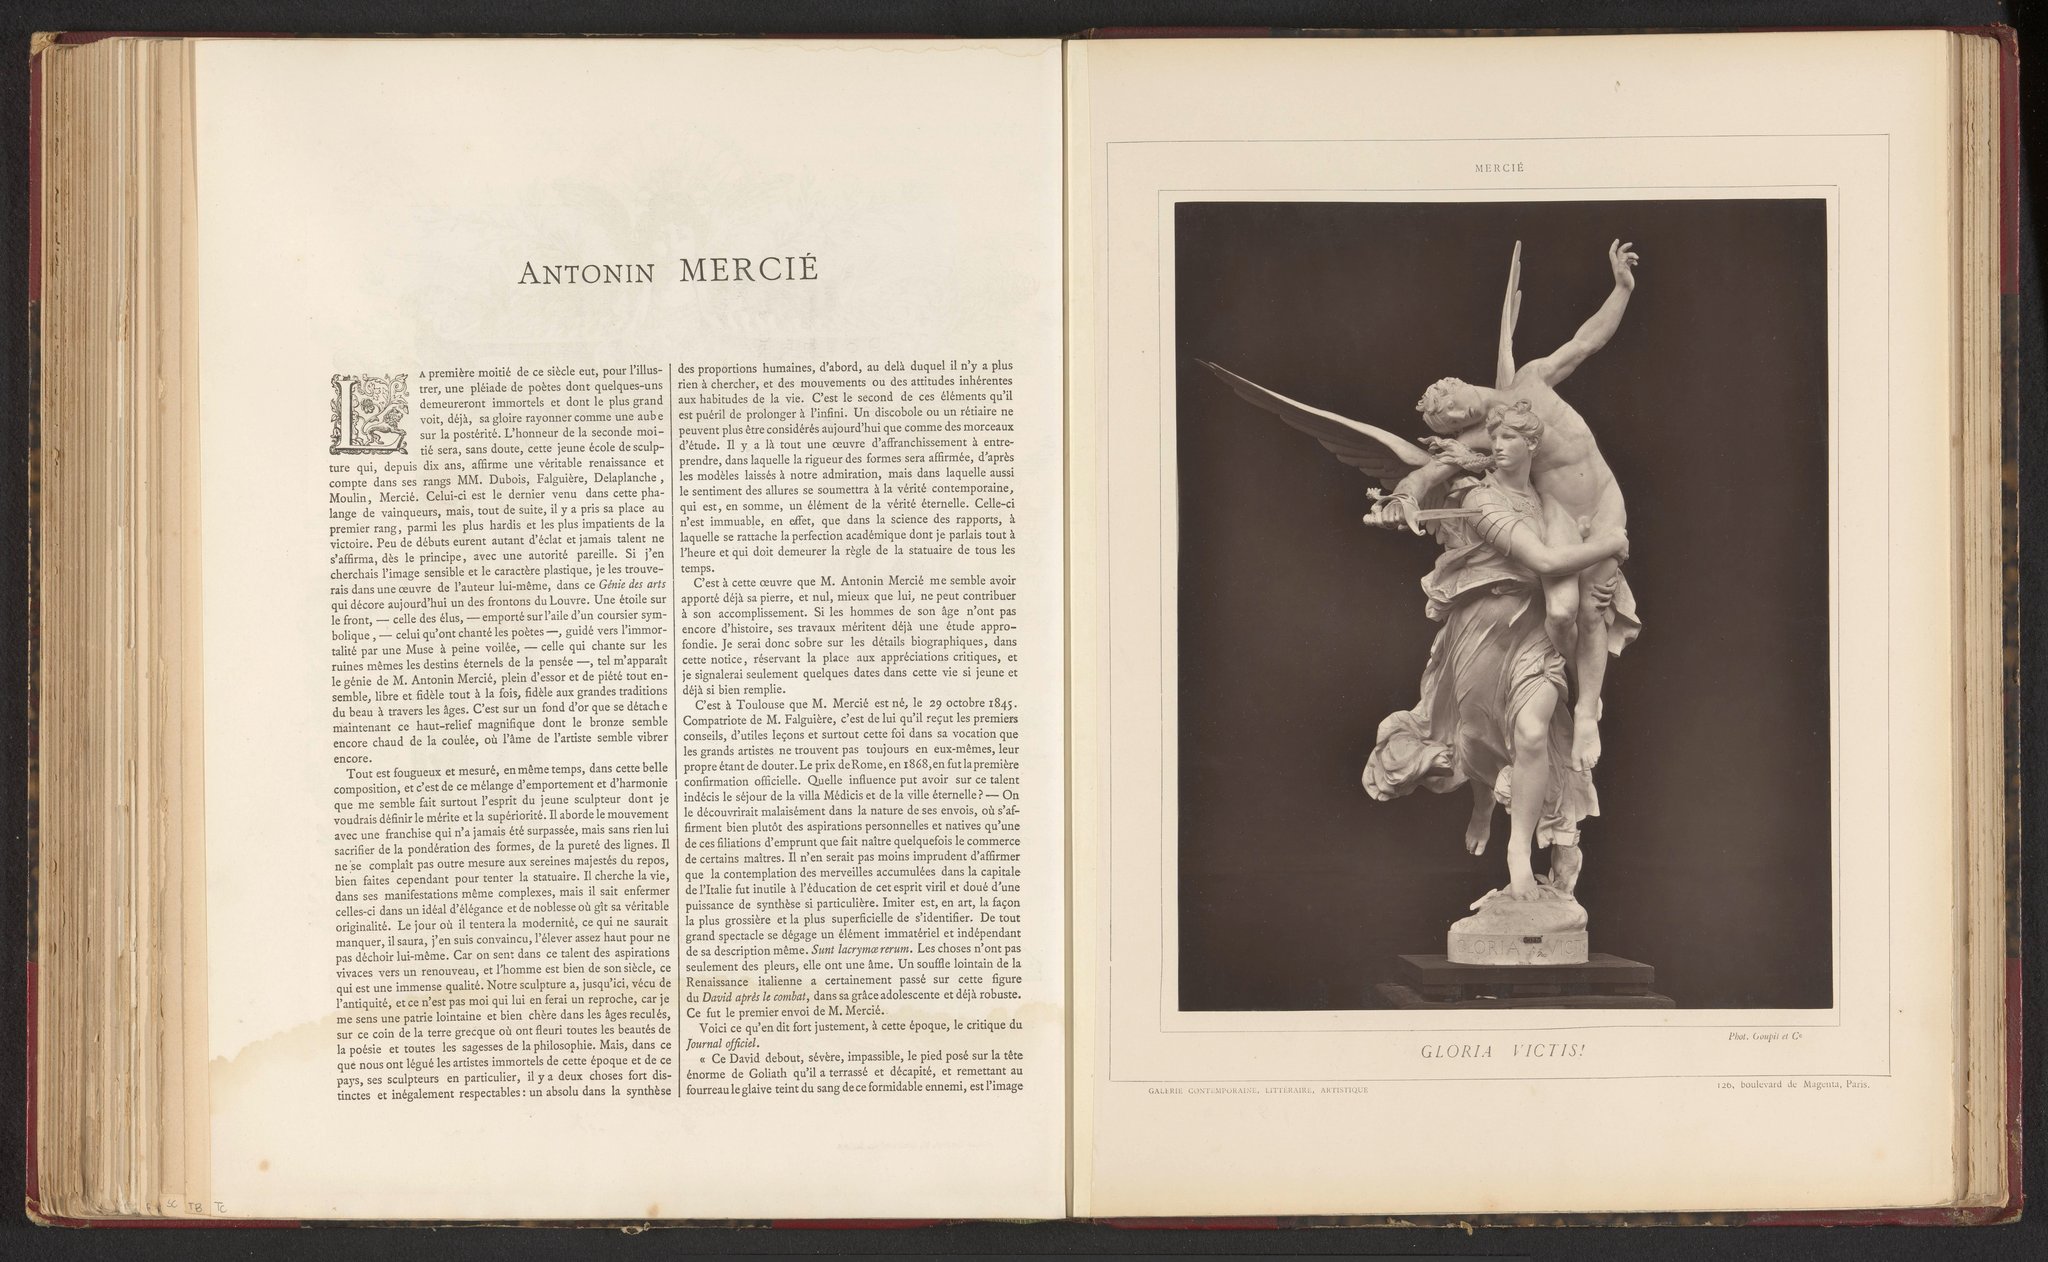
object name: page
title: Gloria Victis!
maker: Anonymous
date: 1876-1879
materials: paper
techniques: woodburytype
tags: piece of sculpture, reproduction of a piece of sculpture, angels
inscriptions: inscription: ‘126, boul. Magenta.-Paris.’